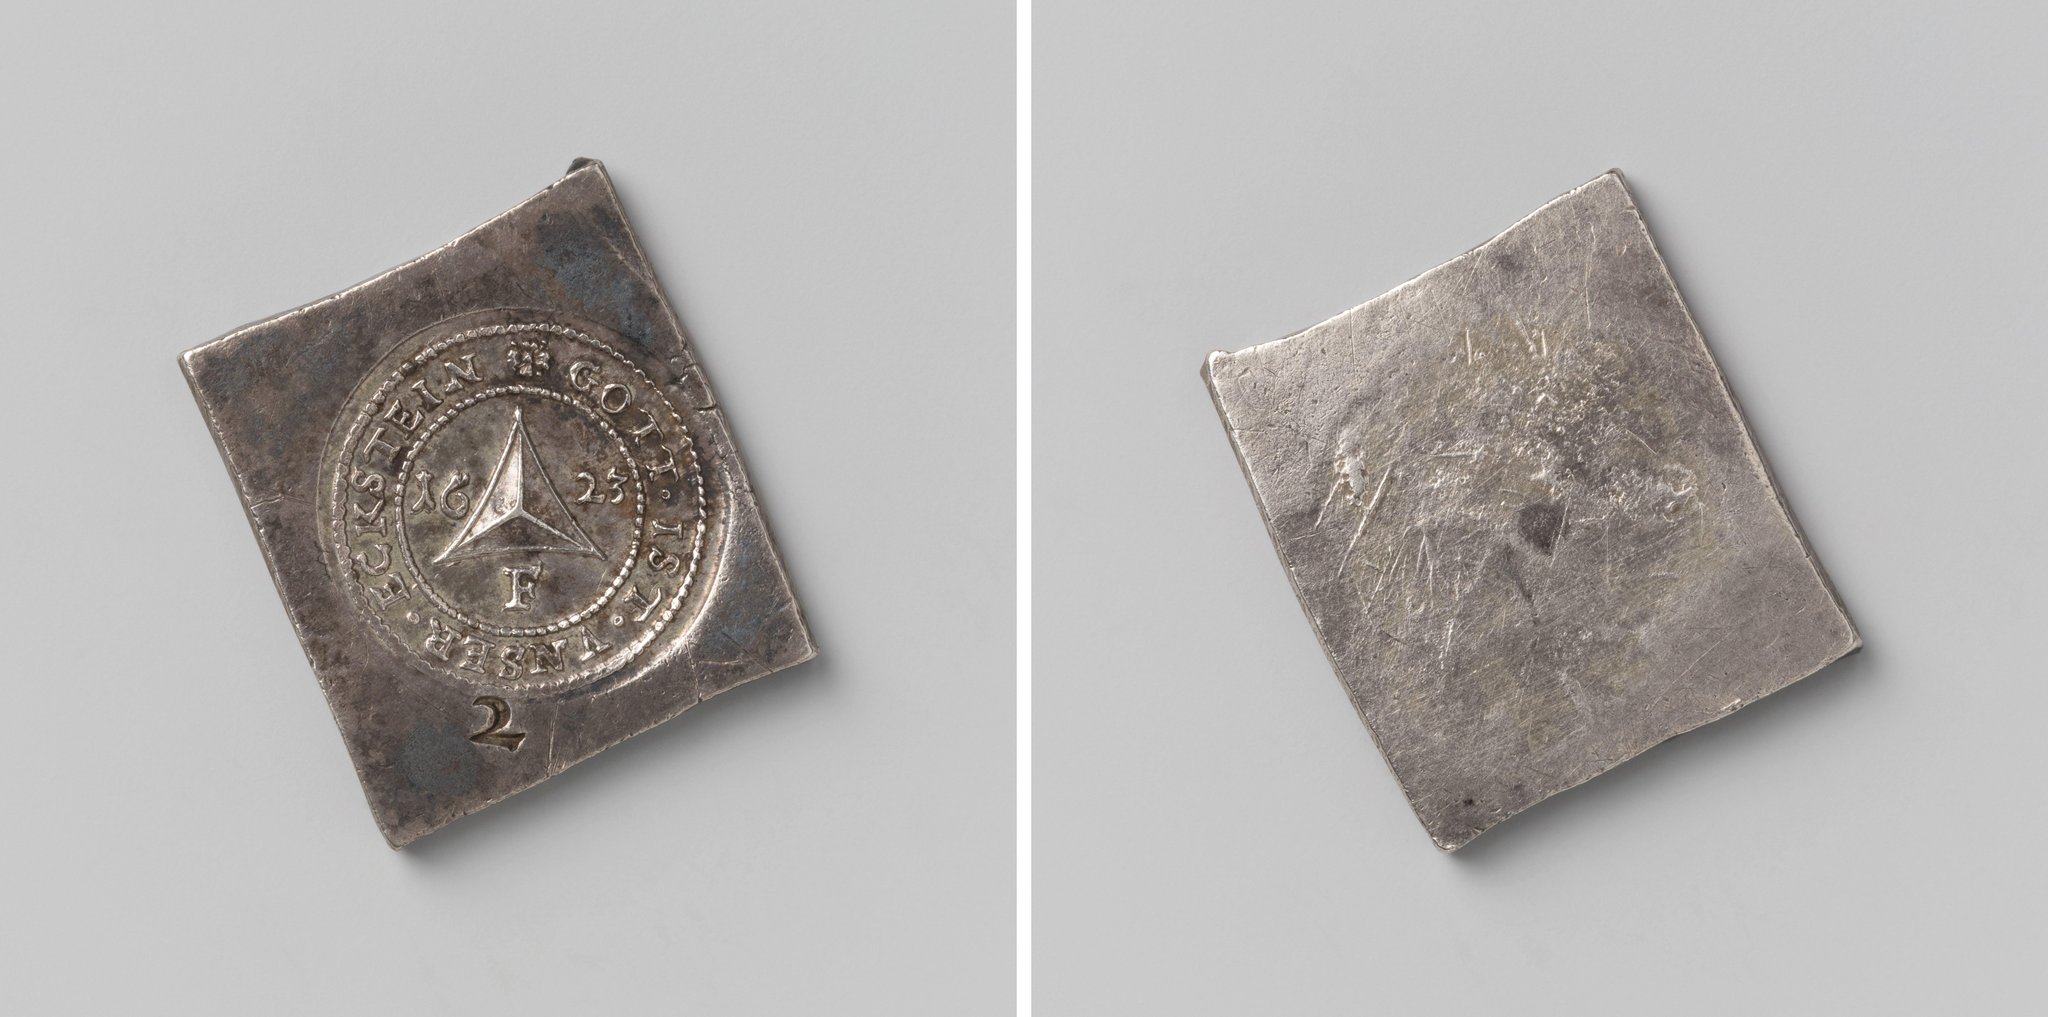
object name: coin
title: halve taler; twee eenheden, noodmunt uit Frankenthal, geslagen tijdens het beleg door Verdugo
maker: Anonymous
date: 1623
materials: silver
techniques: striking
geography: frankenthal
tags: bad kreuznach, generaal, wilhelm von verdugo (graaf), frankenthal, beleg van frankenthal (1623)